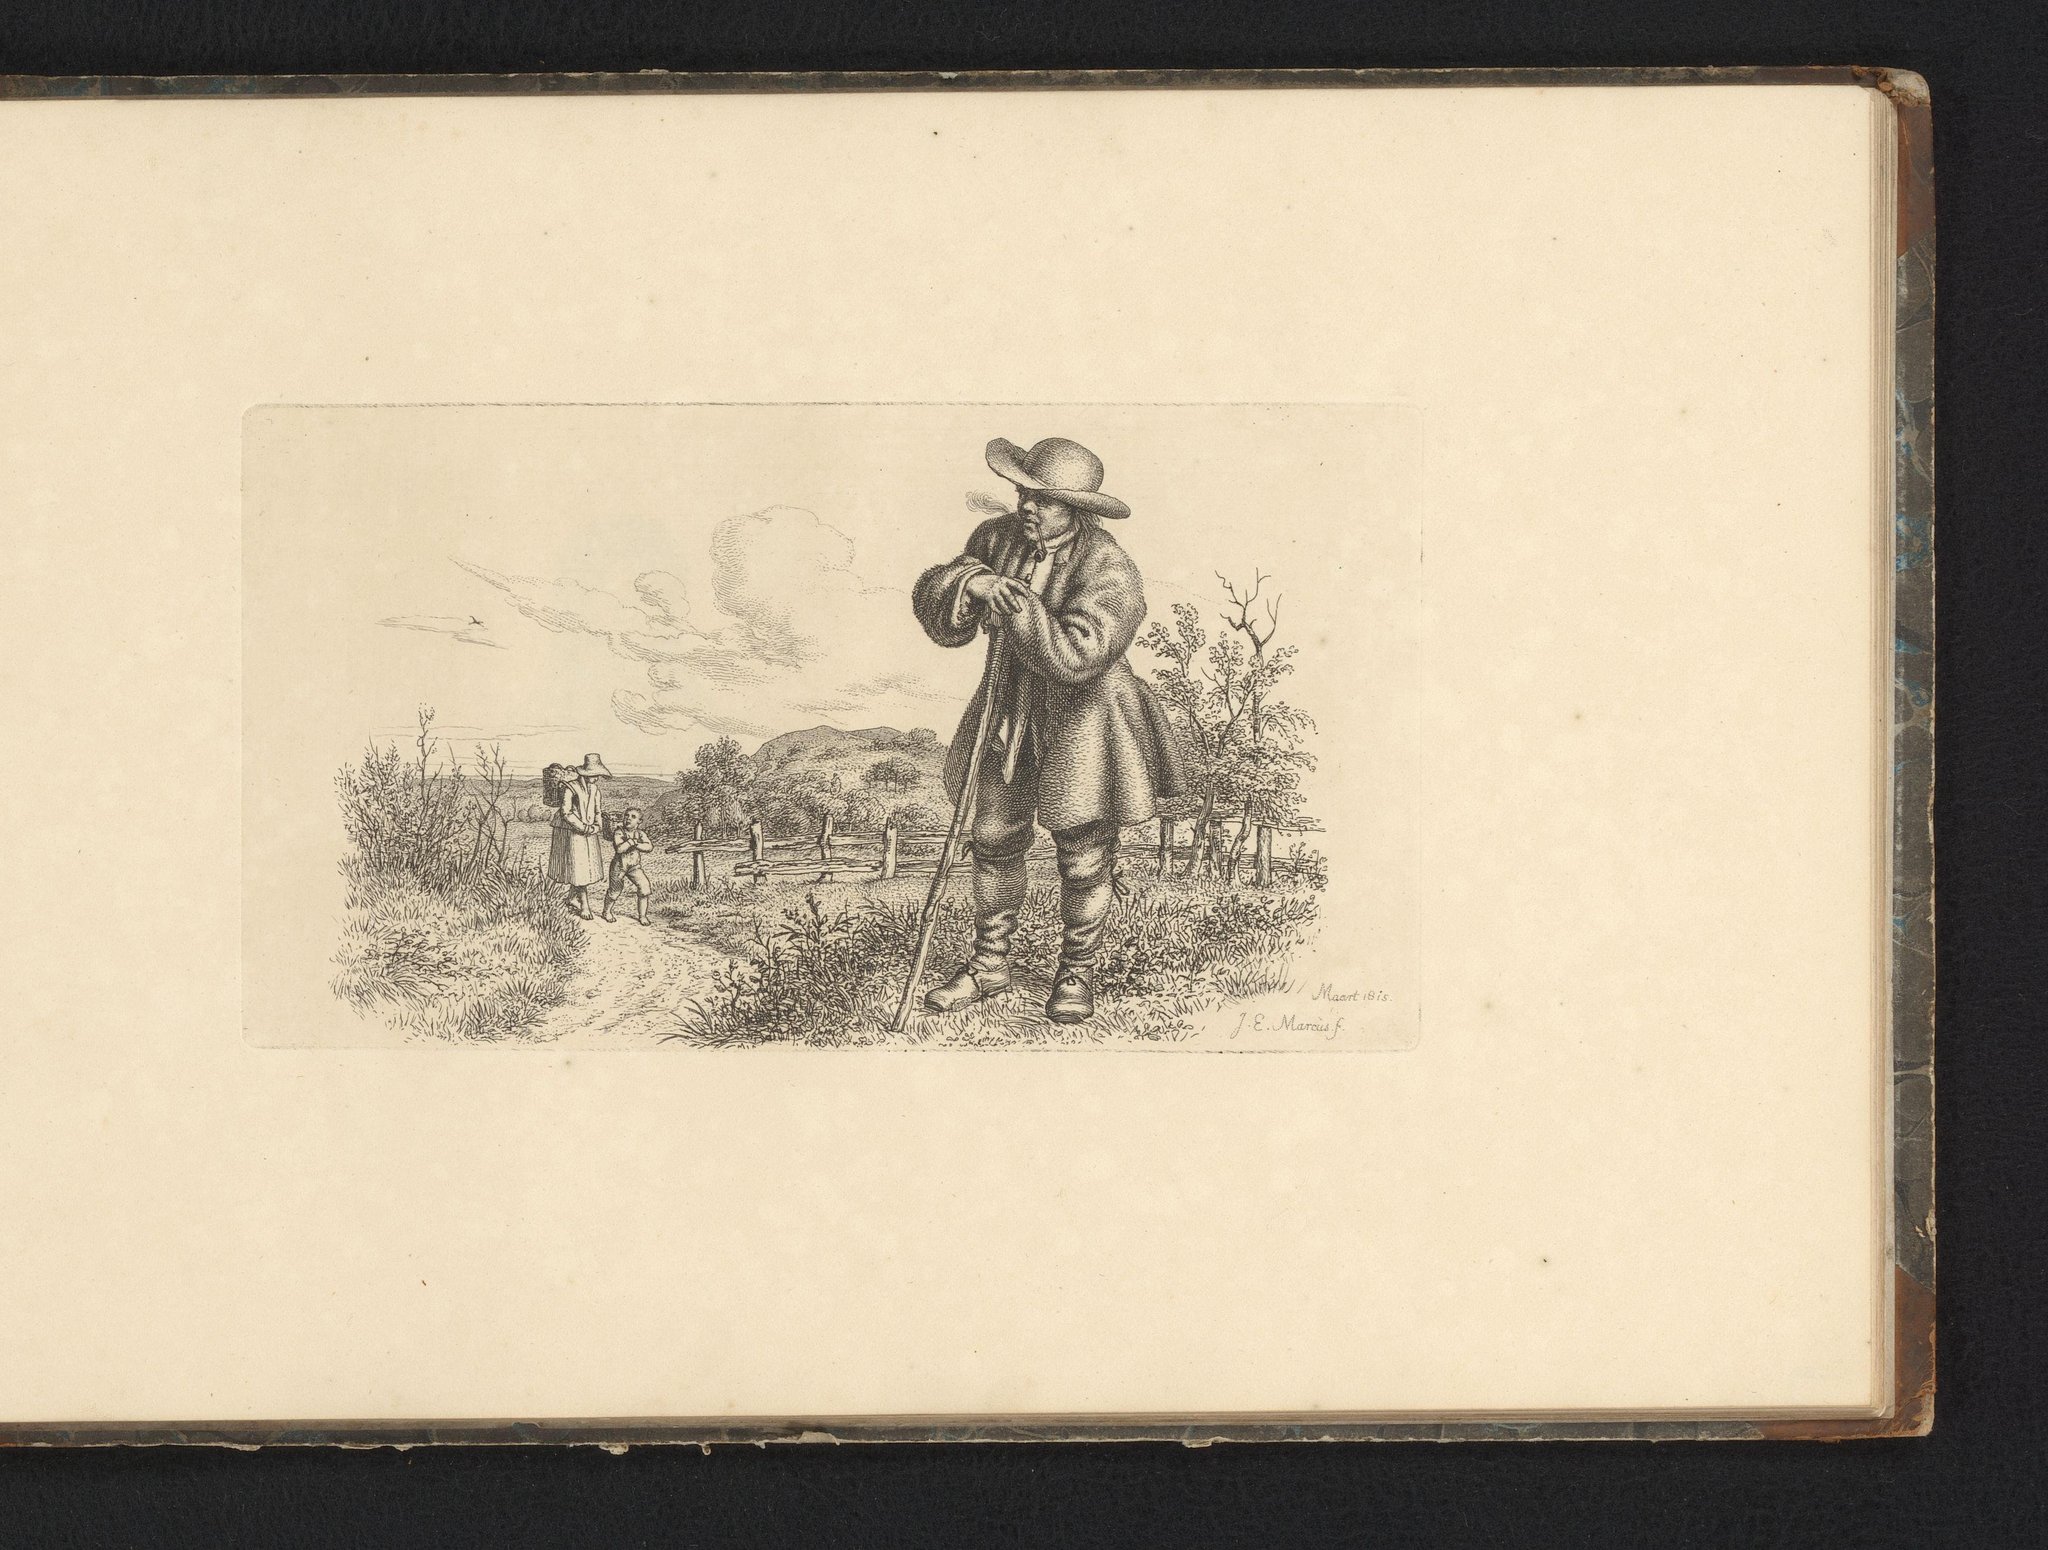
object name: album leaf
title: Man leunend op een stok en een vrouw met een kind op een landweg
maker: jacob ernst marcus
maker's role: draughtsman, print maker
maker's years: 1774-1826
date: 1803-1815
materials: paper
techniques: etching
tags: mother and son(s) (family group), walking-stick, staff, carrying something in basket, bag, rucksack, etc.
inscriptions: date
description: Deze prent maakt deel uit van een album.